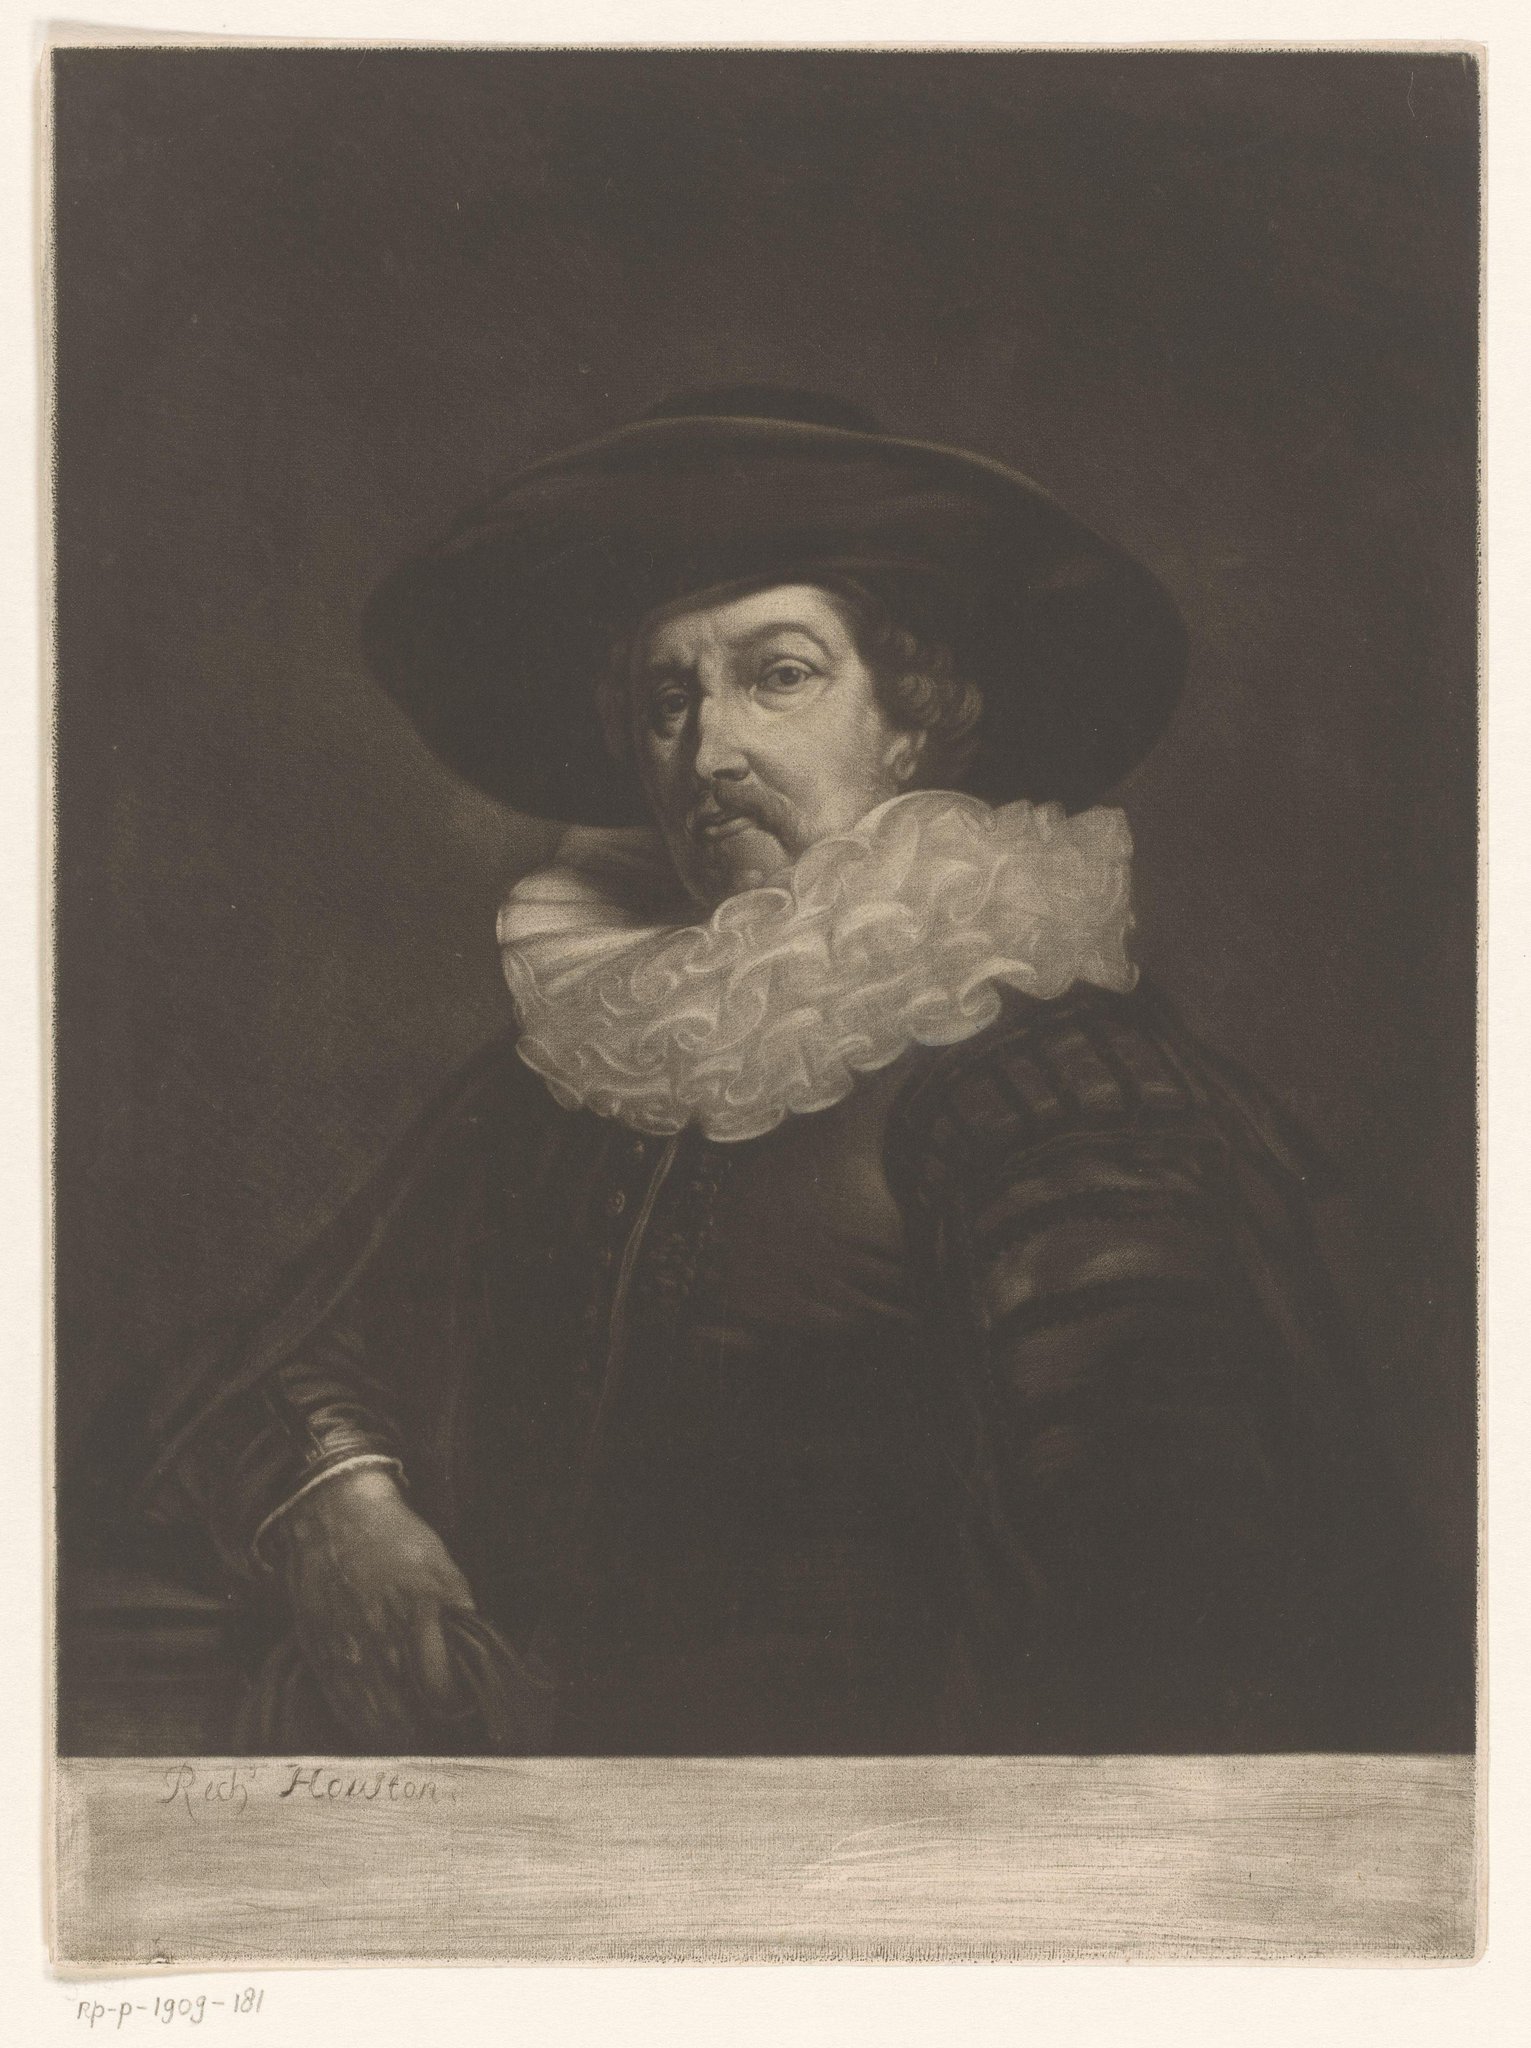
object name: print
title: Portret van een onbekende man met een geplooide kraag en hoed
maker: richard houston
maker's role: print maker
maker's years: 1721-1775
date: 1731-1775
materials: paper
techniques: mezzotint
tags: historical persons, neck-gear: collar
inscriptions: collector's mark: Lugt 2228